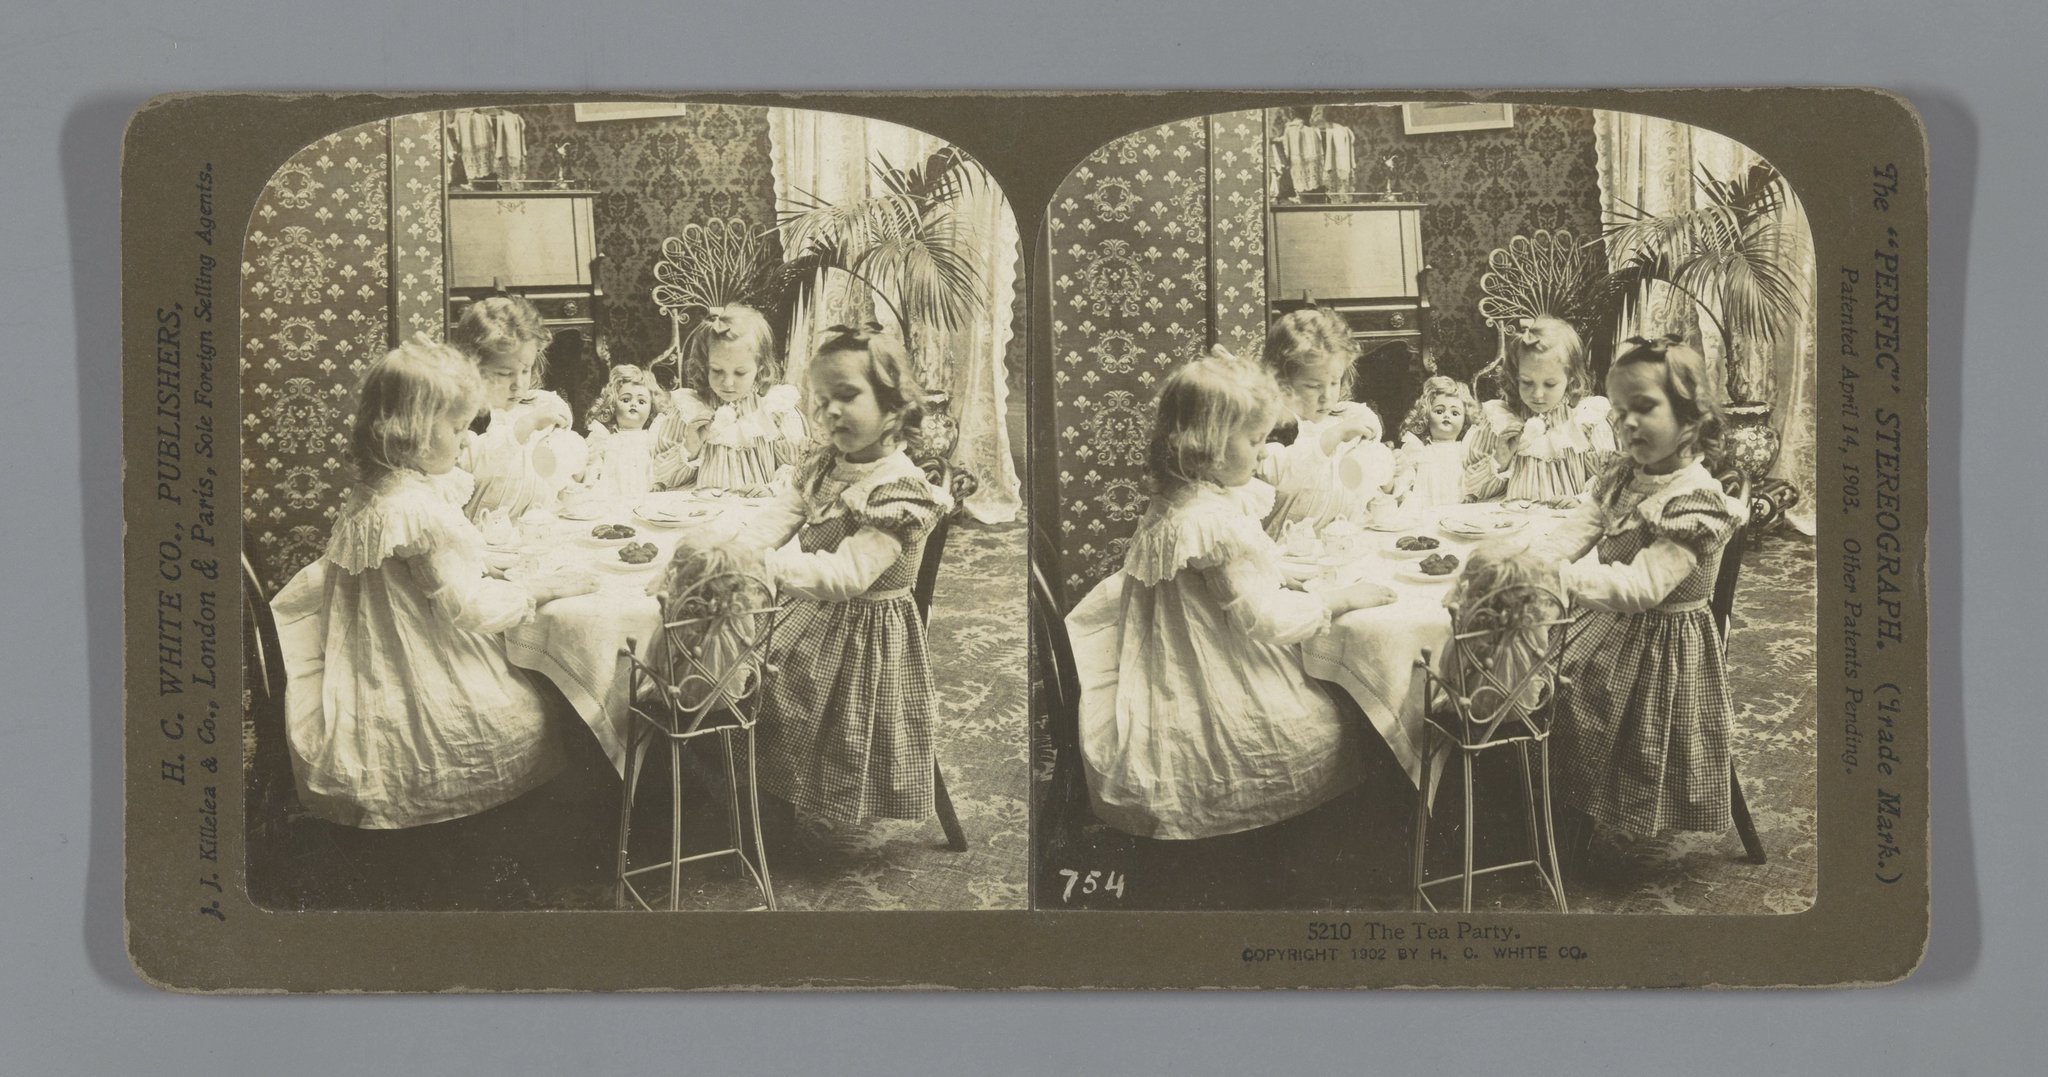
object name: stereograph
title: The Tea Party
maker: h.c. white & co. publishers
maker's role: fotograaf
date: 1902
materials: cardboard, photographic support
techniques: gelatin silver print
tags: toy tea-set, afternoon tea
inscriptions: : ‘The 'Perfec' Stereograph (Trade Mark), Patented April 14, 1903. Other Patents Pending’, number: ‘5210’, number: ‘754’